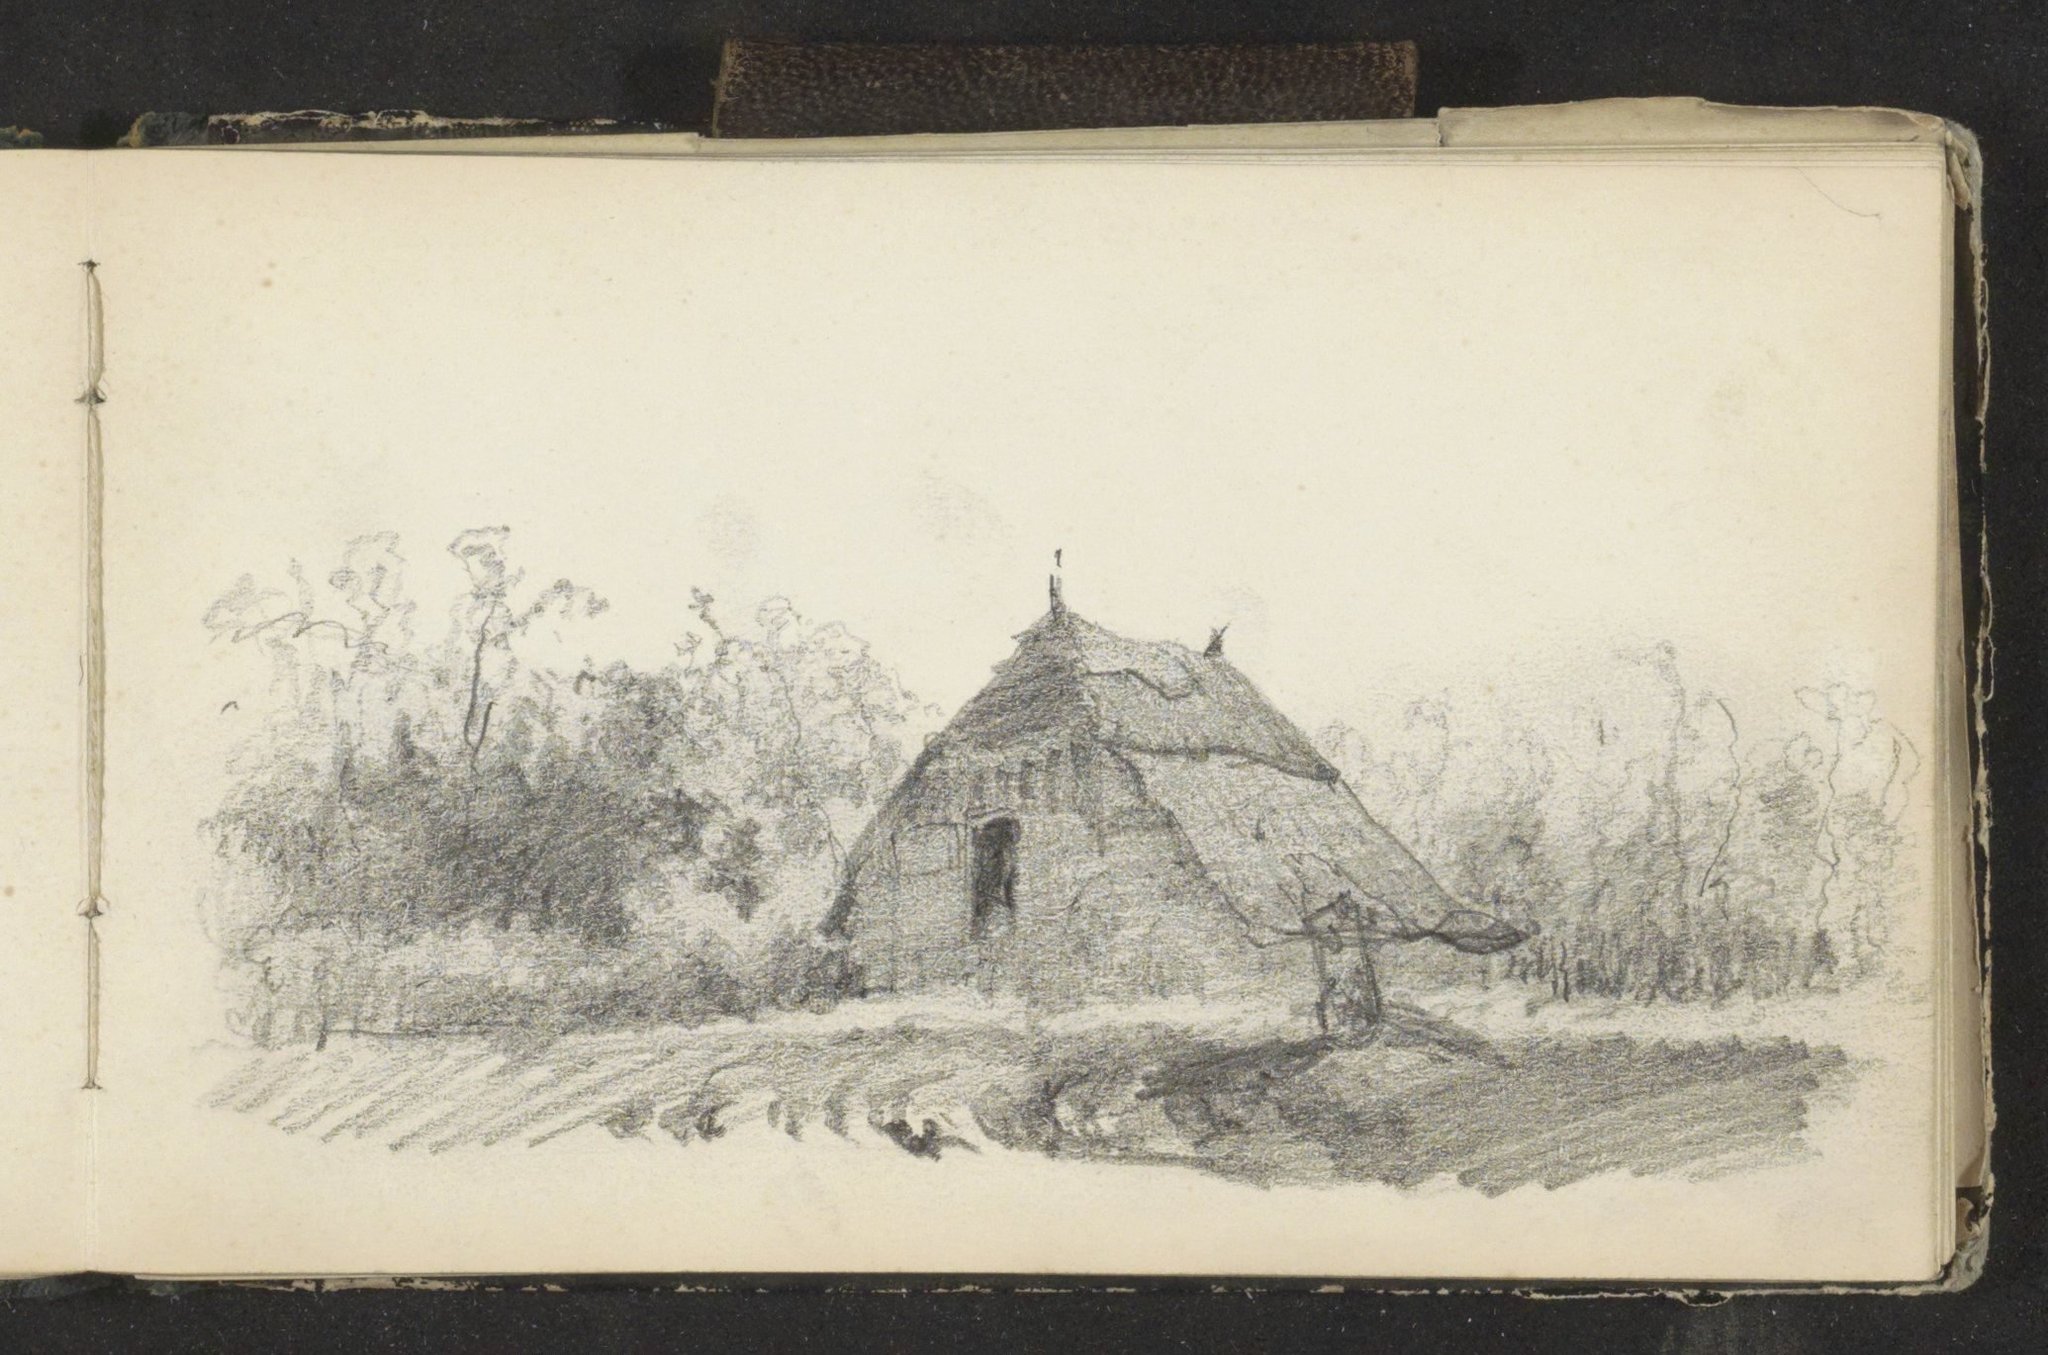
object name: sketchbook leaf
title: Huis met een rieten kap op het platteland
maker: maria vos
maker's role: draughtsman, painter, print maker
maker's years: 1824-1906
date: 1834-1906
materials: paper, pencil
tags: rural housing, e.g. country-house, villa, cottage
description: Blad 14 recto uit een schetsboek met 46 bladen.